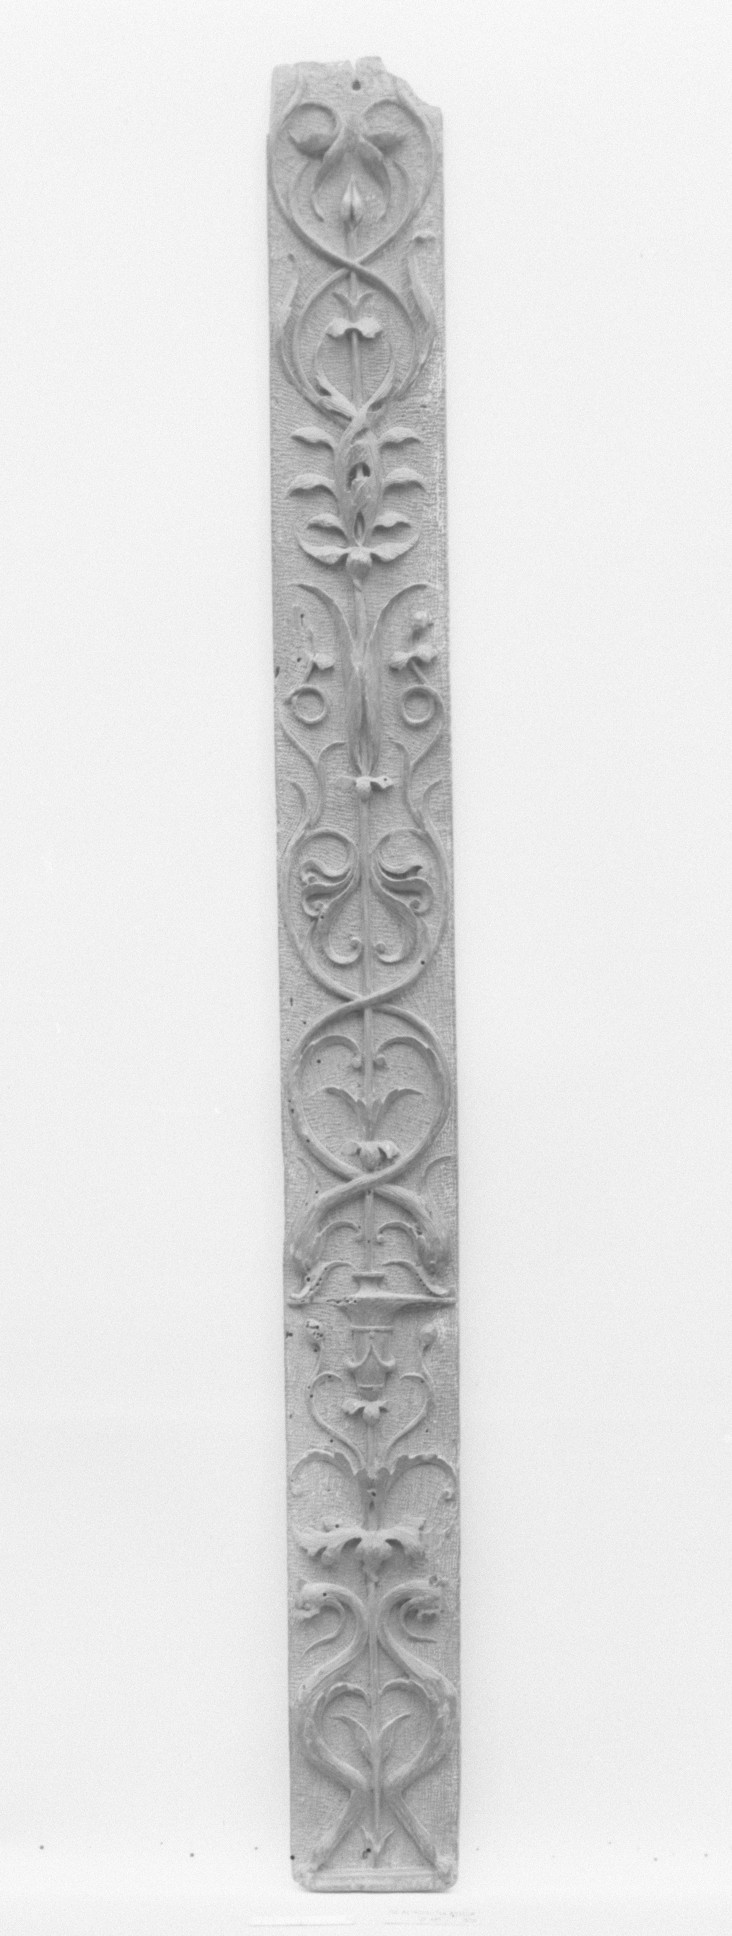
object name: pilaster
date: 1501-1600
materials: wood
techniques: carving, gilding